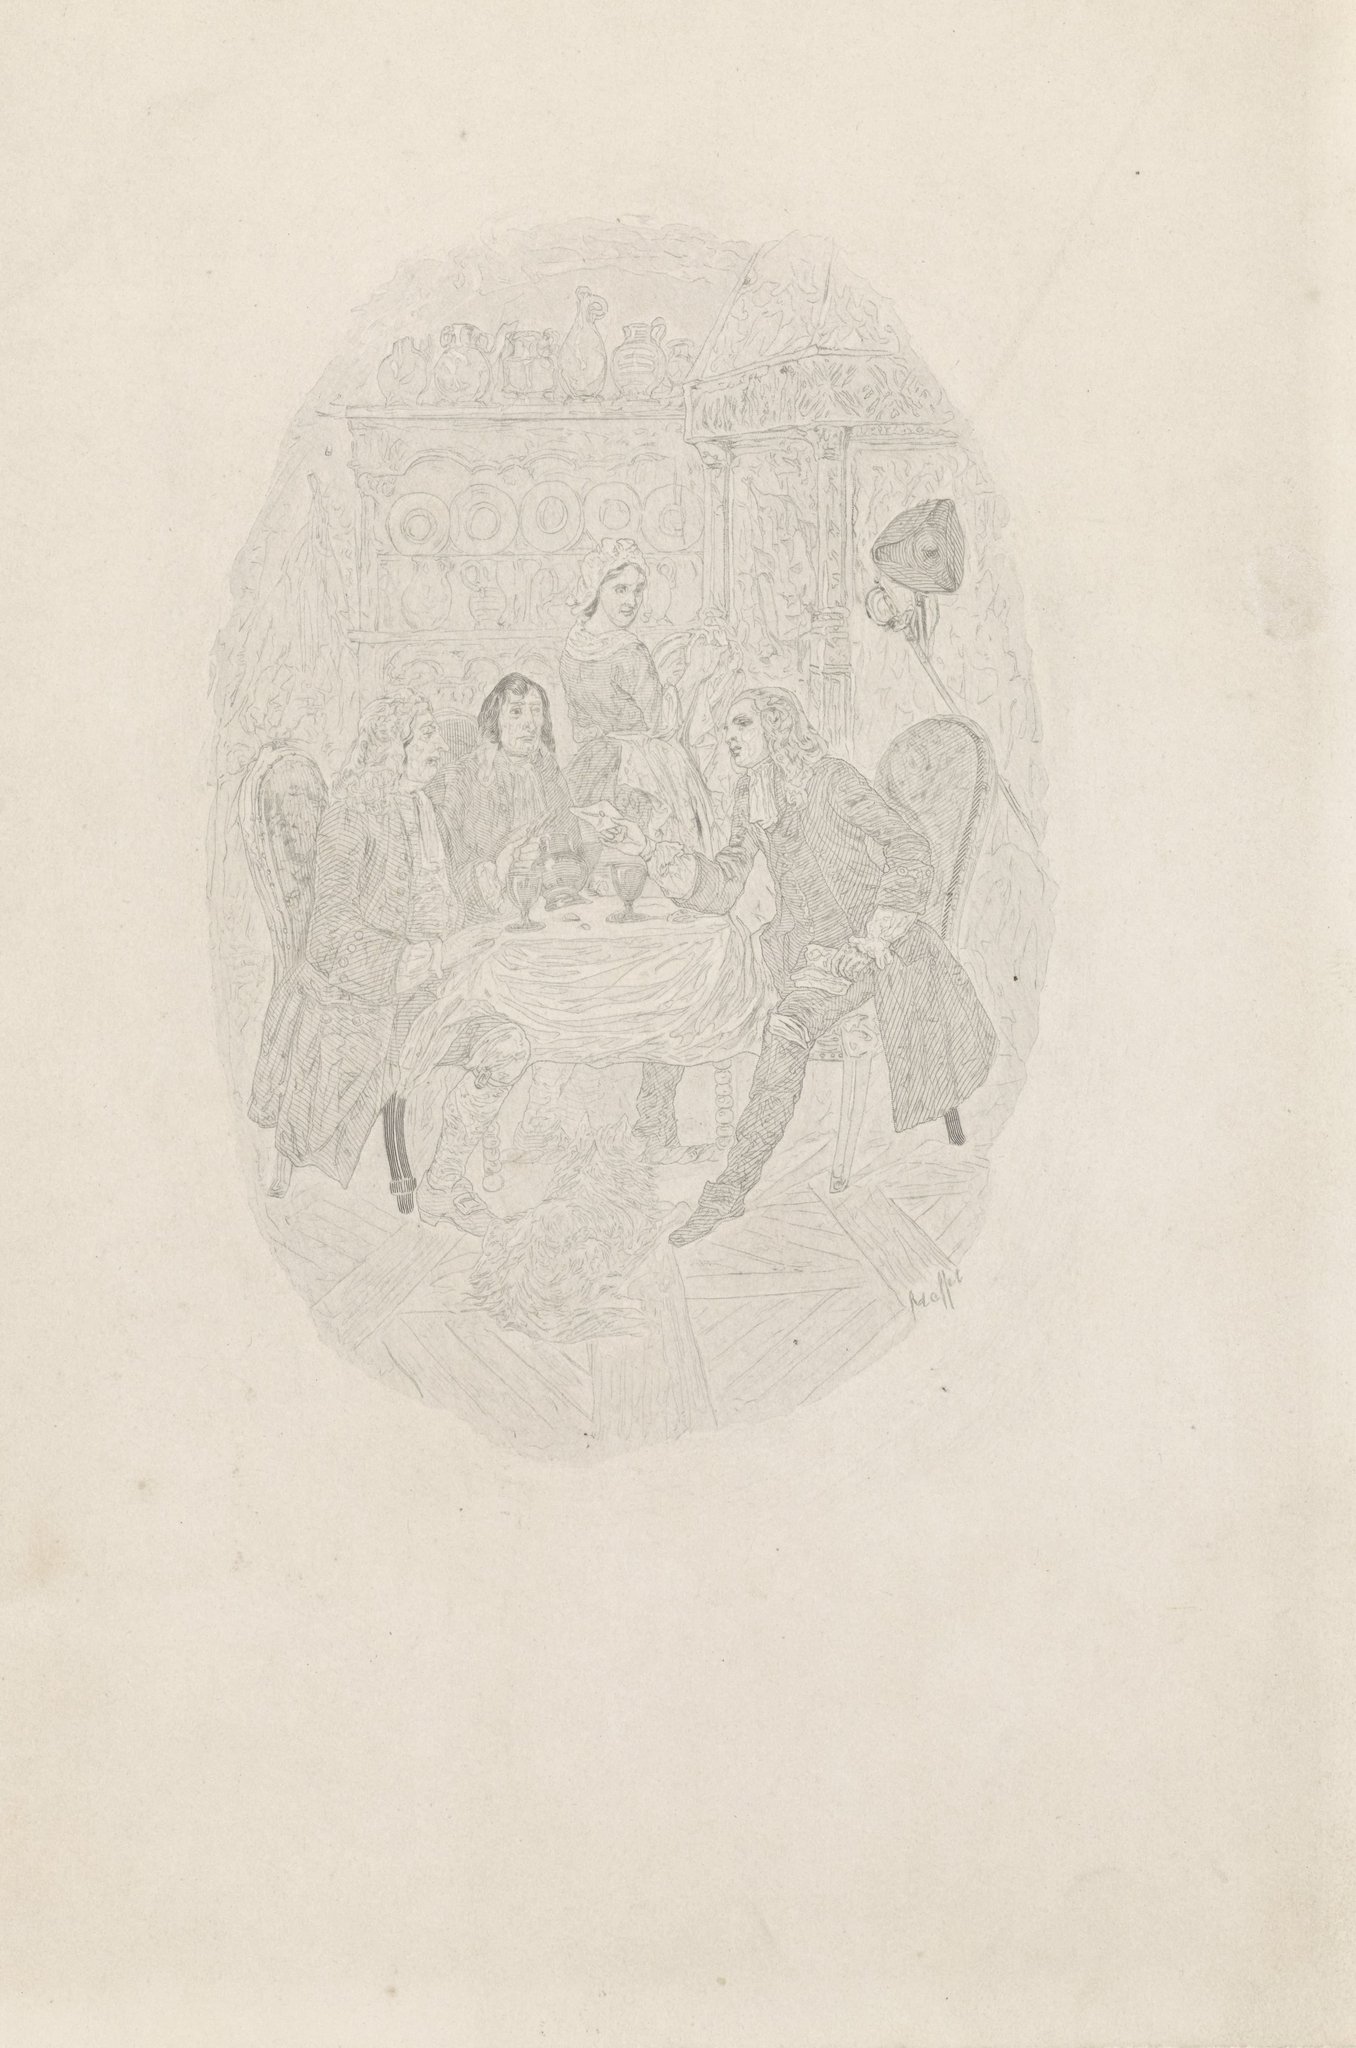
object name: print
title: Drie mannen aan een tafel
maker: johannes de mare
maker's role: draughtsman, print maker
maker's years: 1806-1889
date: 1816-1889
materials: paper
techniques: engraving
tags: table, kitchen-interior, letter, envelope, kitchen-maid, kitchen servant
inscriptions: collector's mark: Lugt 2228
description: Drie mannen aan een tafel in een keukeninterieur, een van hen met een brief in zijn hand. Op de achtergrond een dienstmeid.